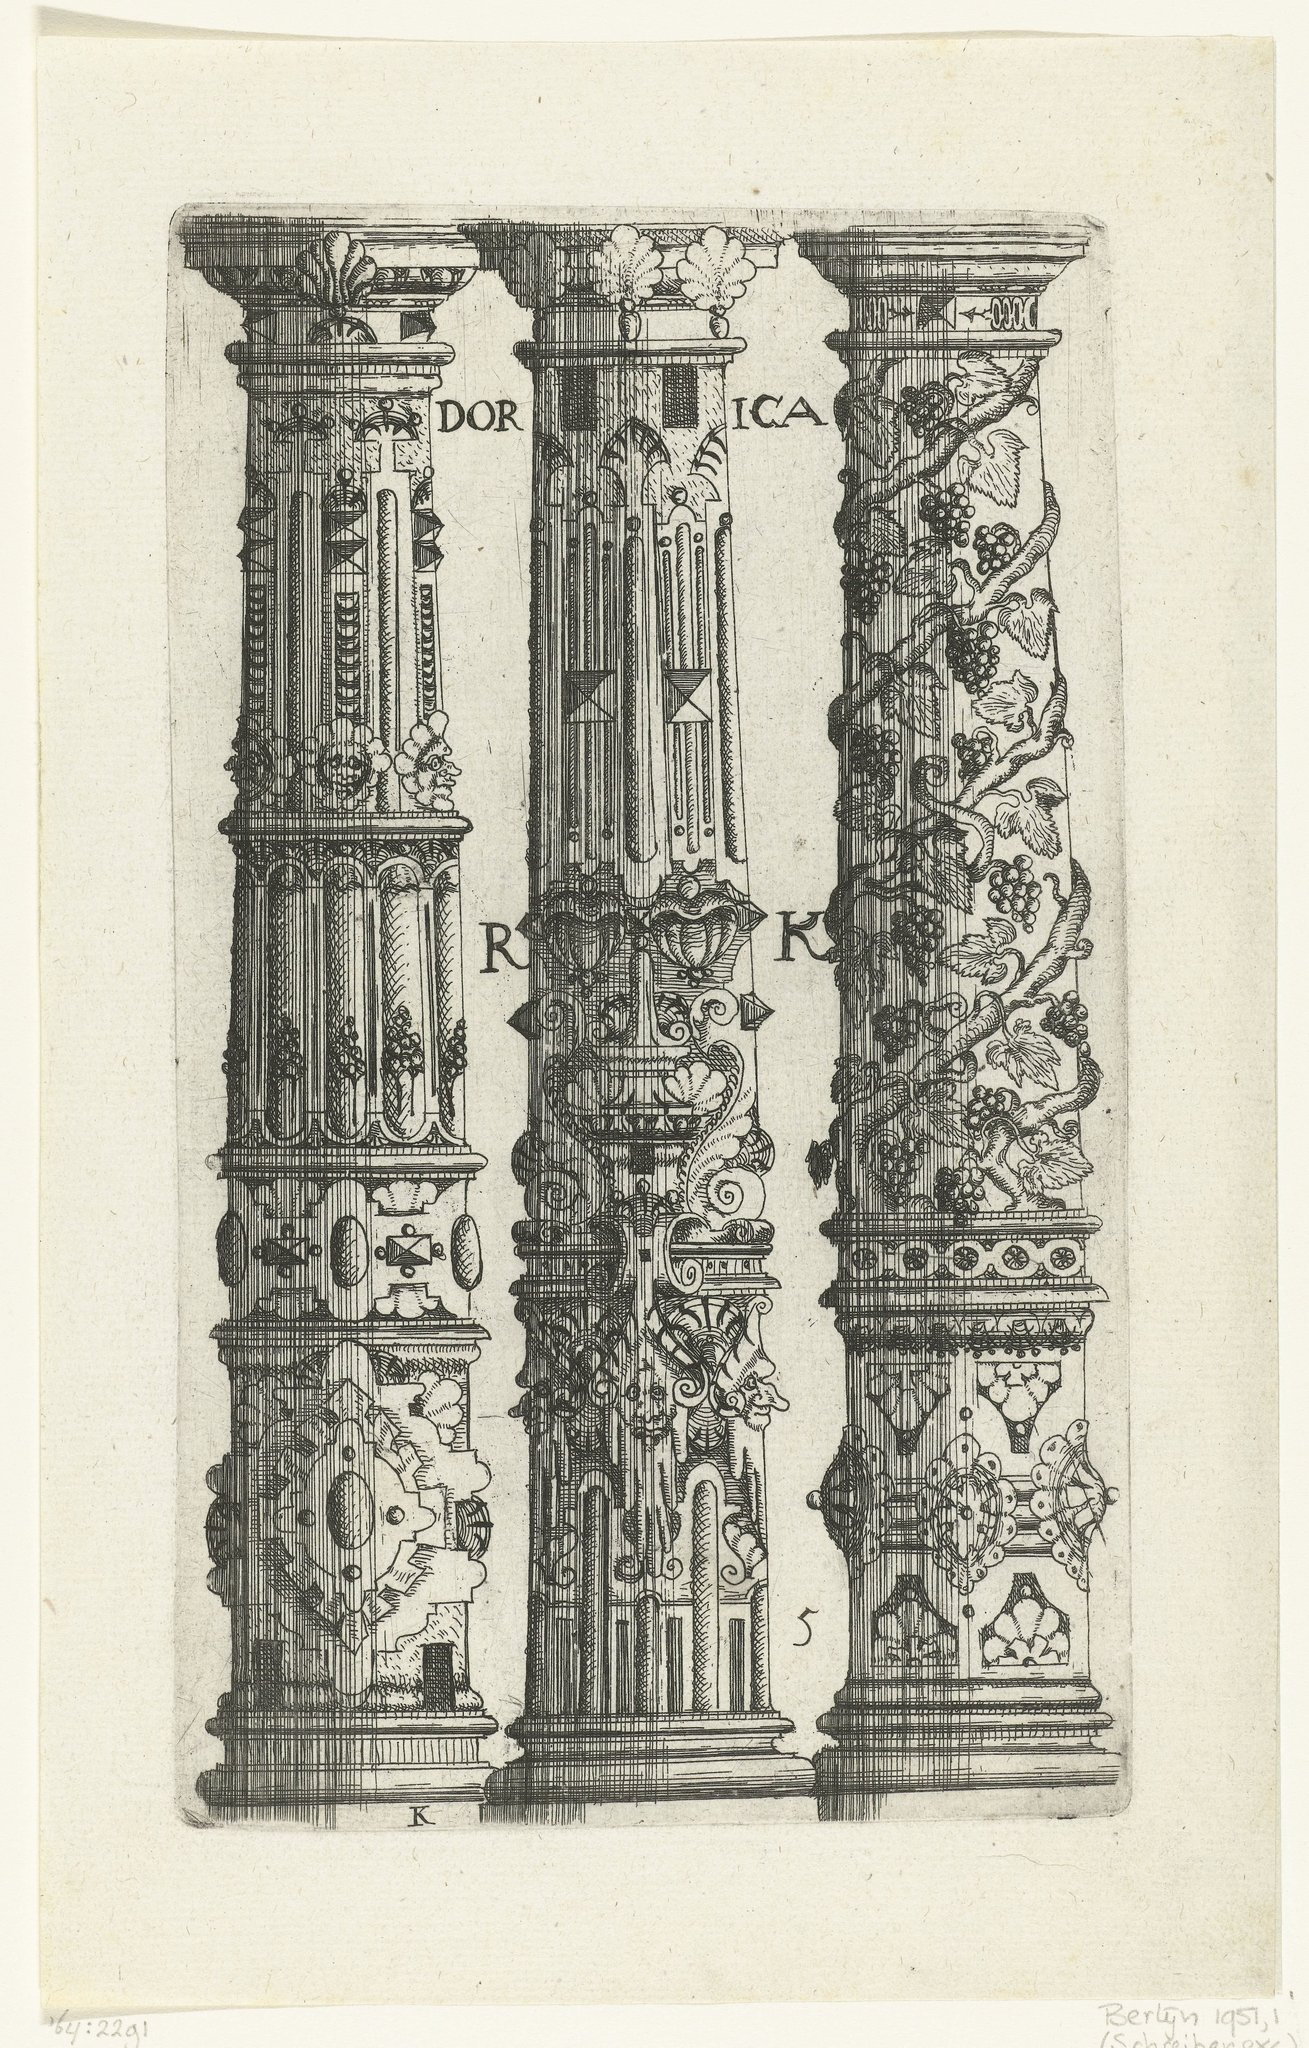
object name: print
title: Dorica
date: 1622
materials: paper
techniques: etching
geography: paris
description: Rond de rechterzuil is een druivenrank gewikkeld.